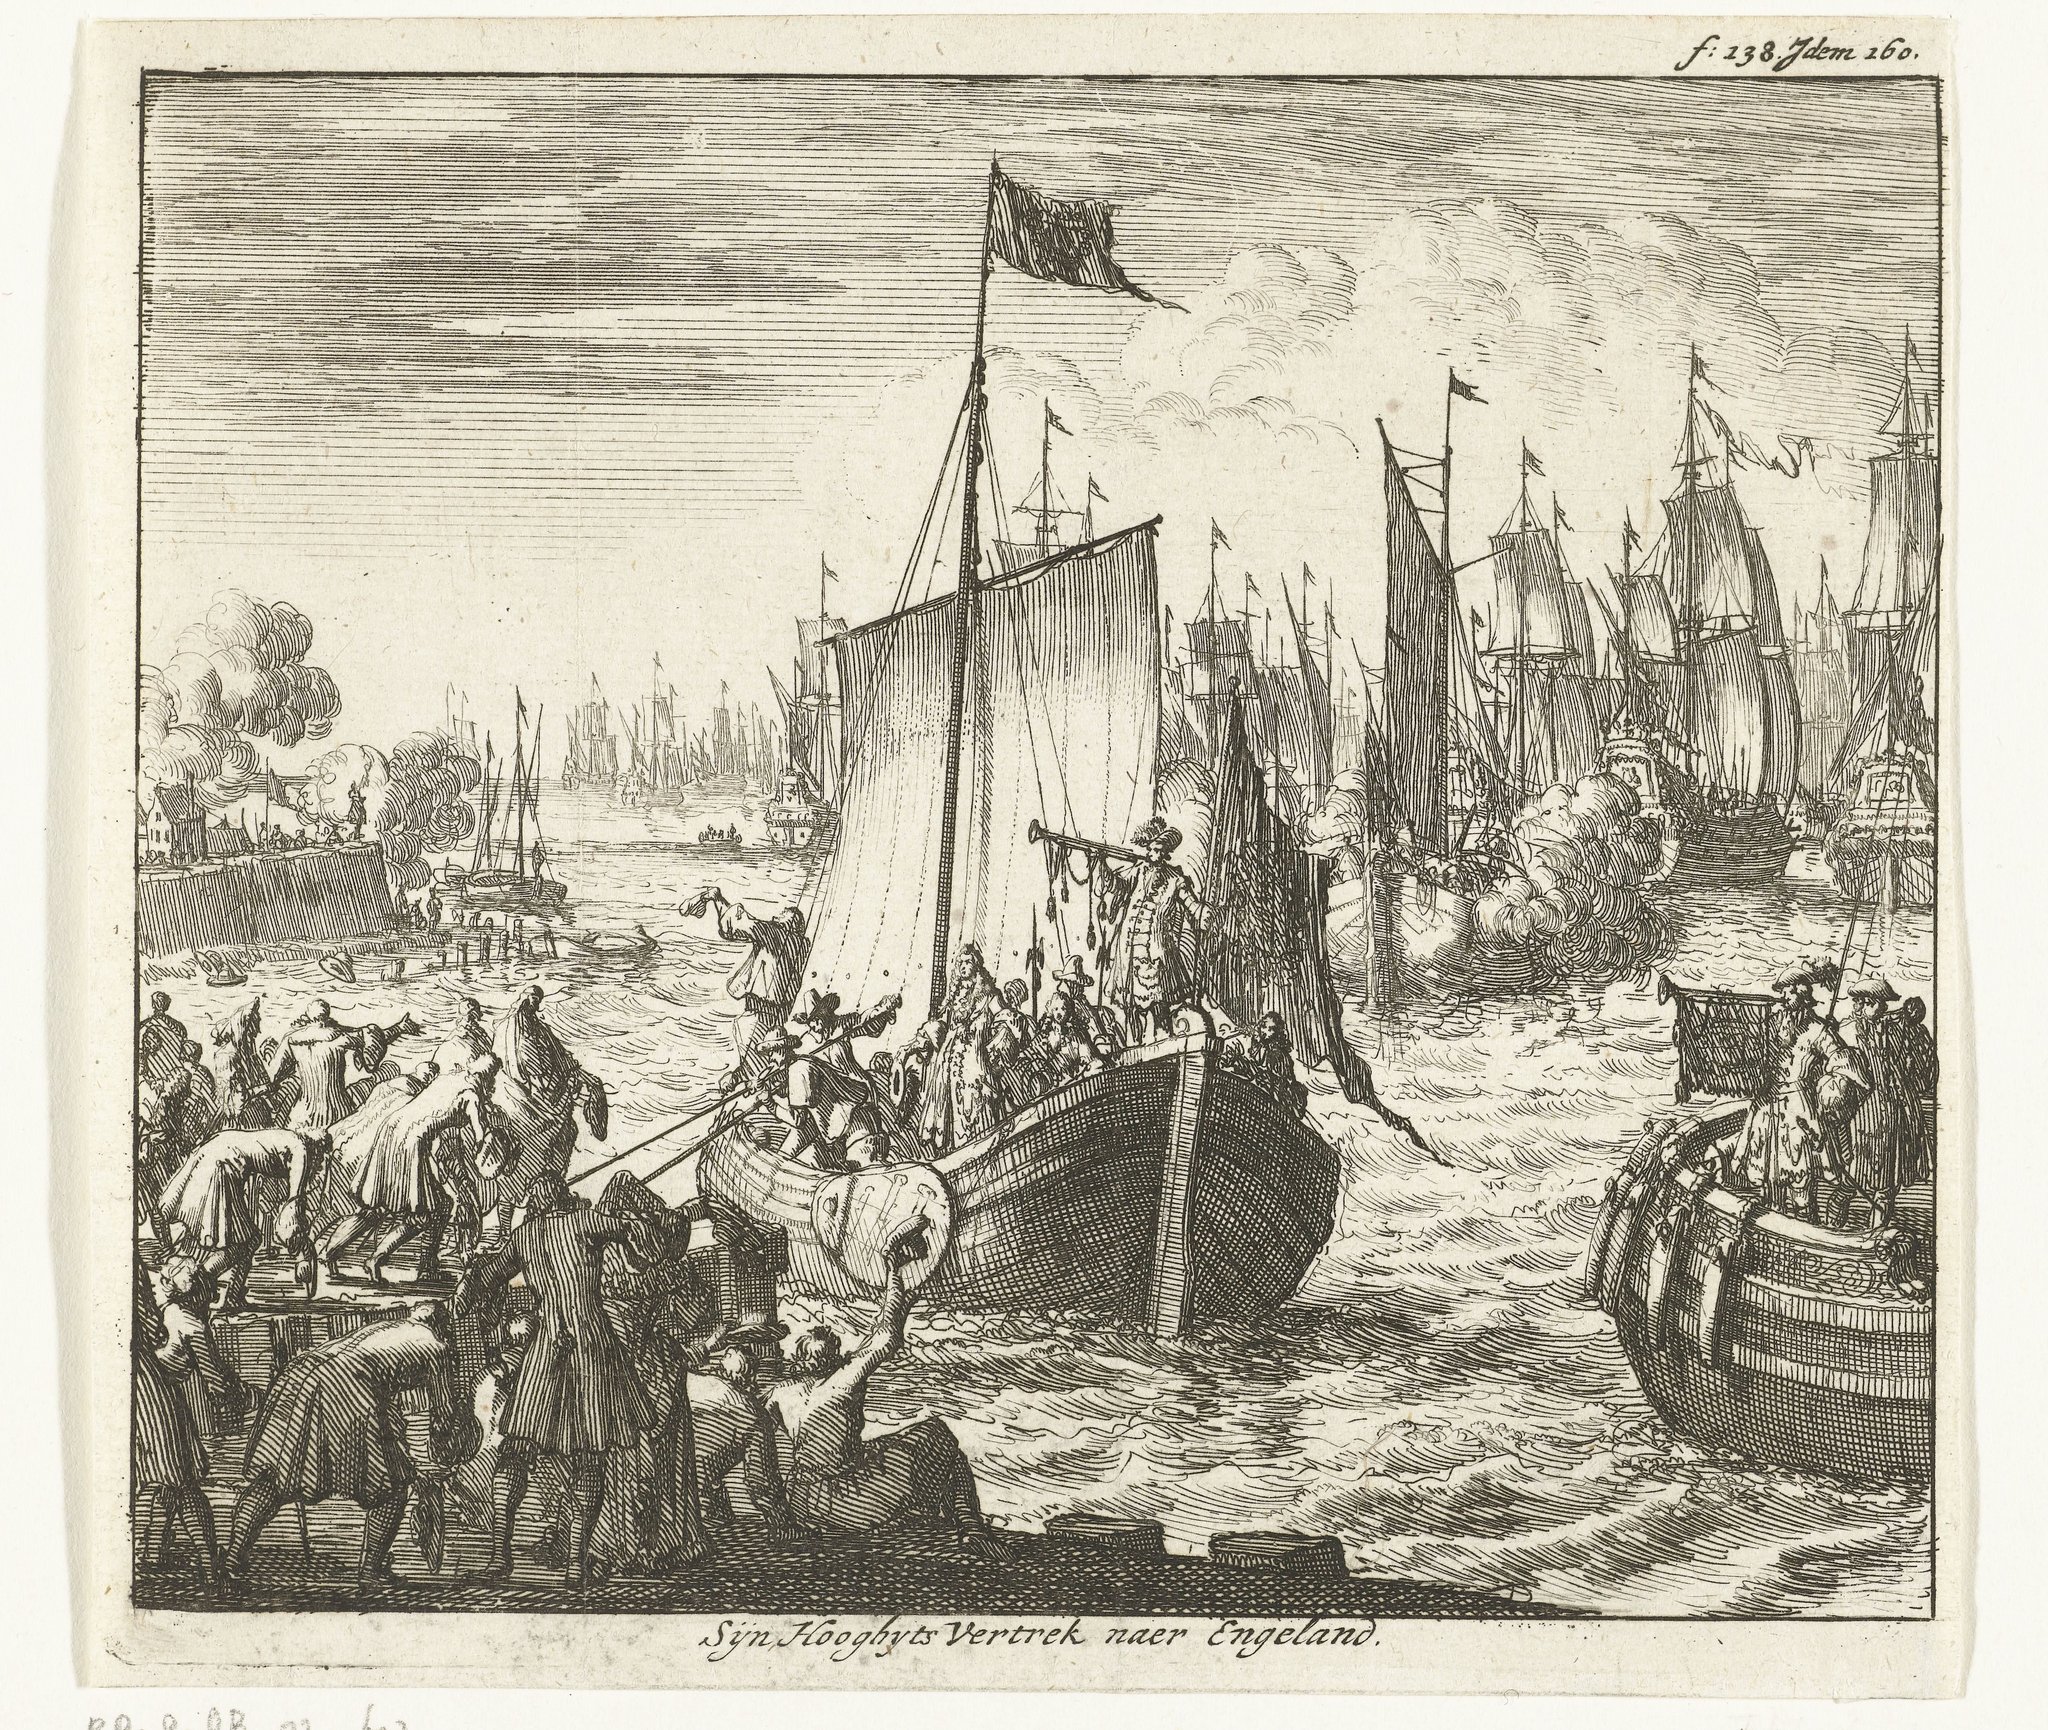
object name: print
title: Syn Hooghyts Vertrek naer Engeland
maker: jan luyken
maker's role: draughtsman, print maker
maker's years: 1649-1712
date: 1689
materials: paper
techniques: etching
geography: northern netherlands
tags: the hague, william iii (prince of orange and king of england, scotland, and ireland), departure ~ travelling, hellevoetsluis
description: Prins Willem III vertrekt met de vloot vanuit Hellevoetsluis naar Engeland, 11 november 1688. De prins neemt op de pier afscheid. Gemerkt rechtsboven: f: 138 Idem 160.